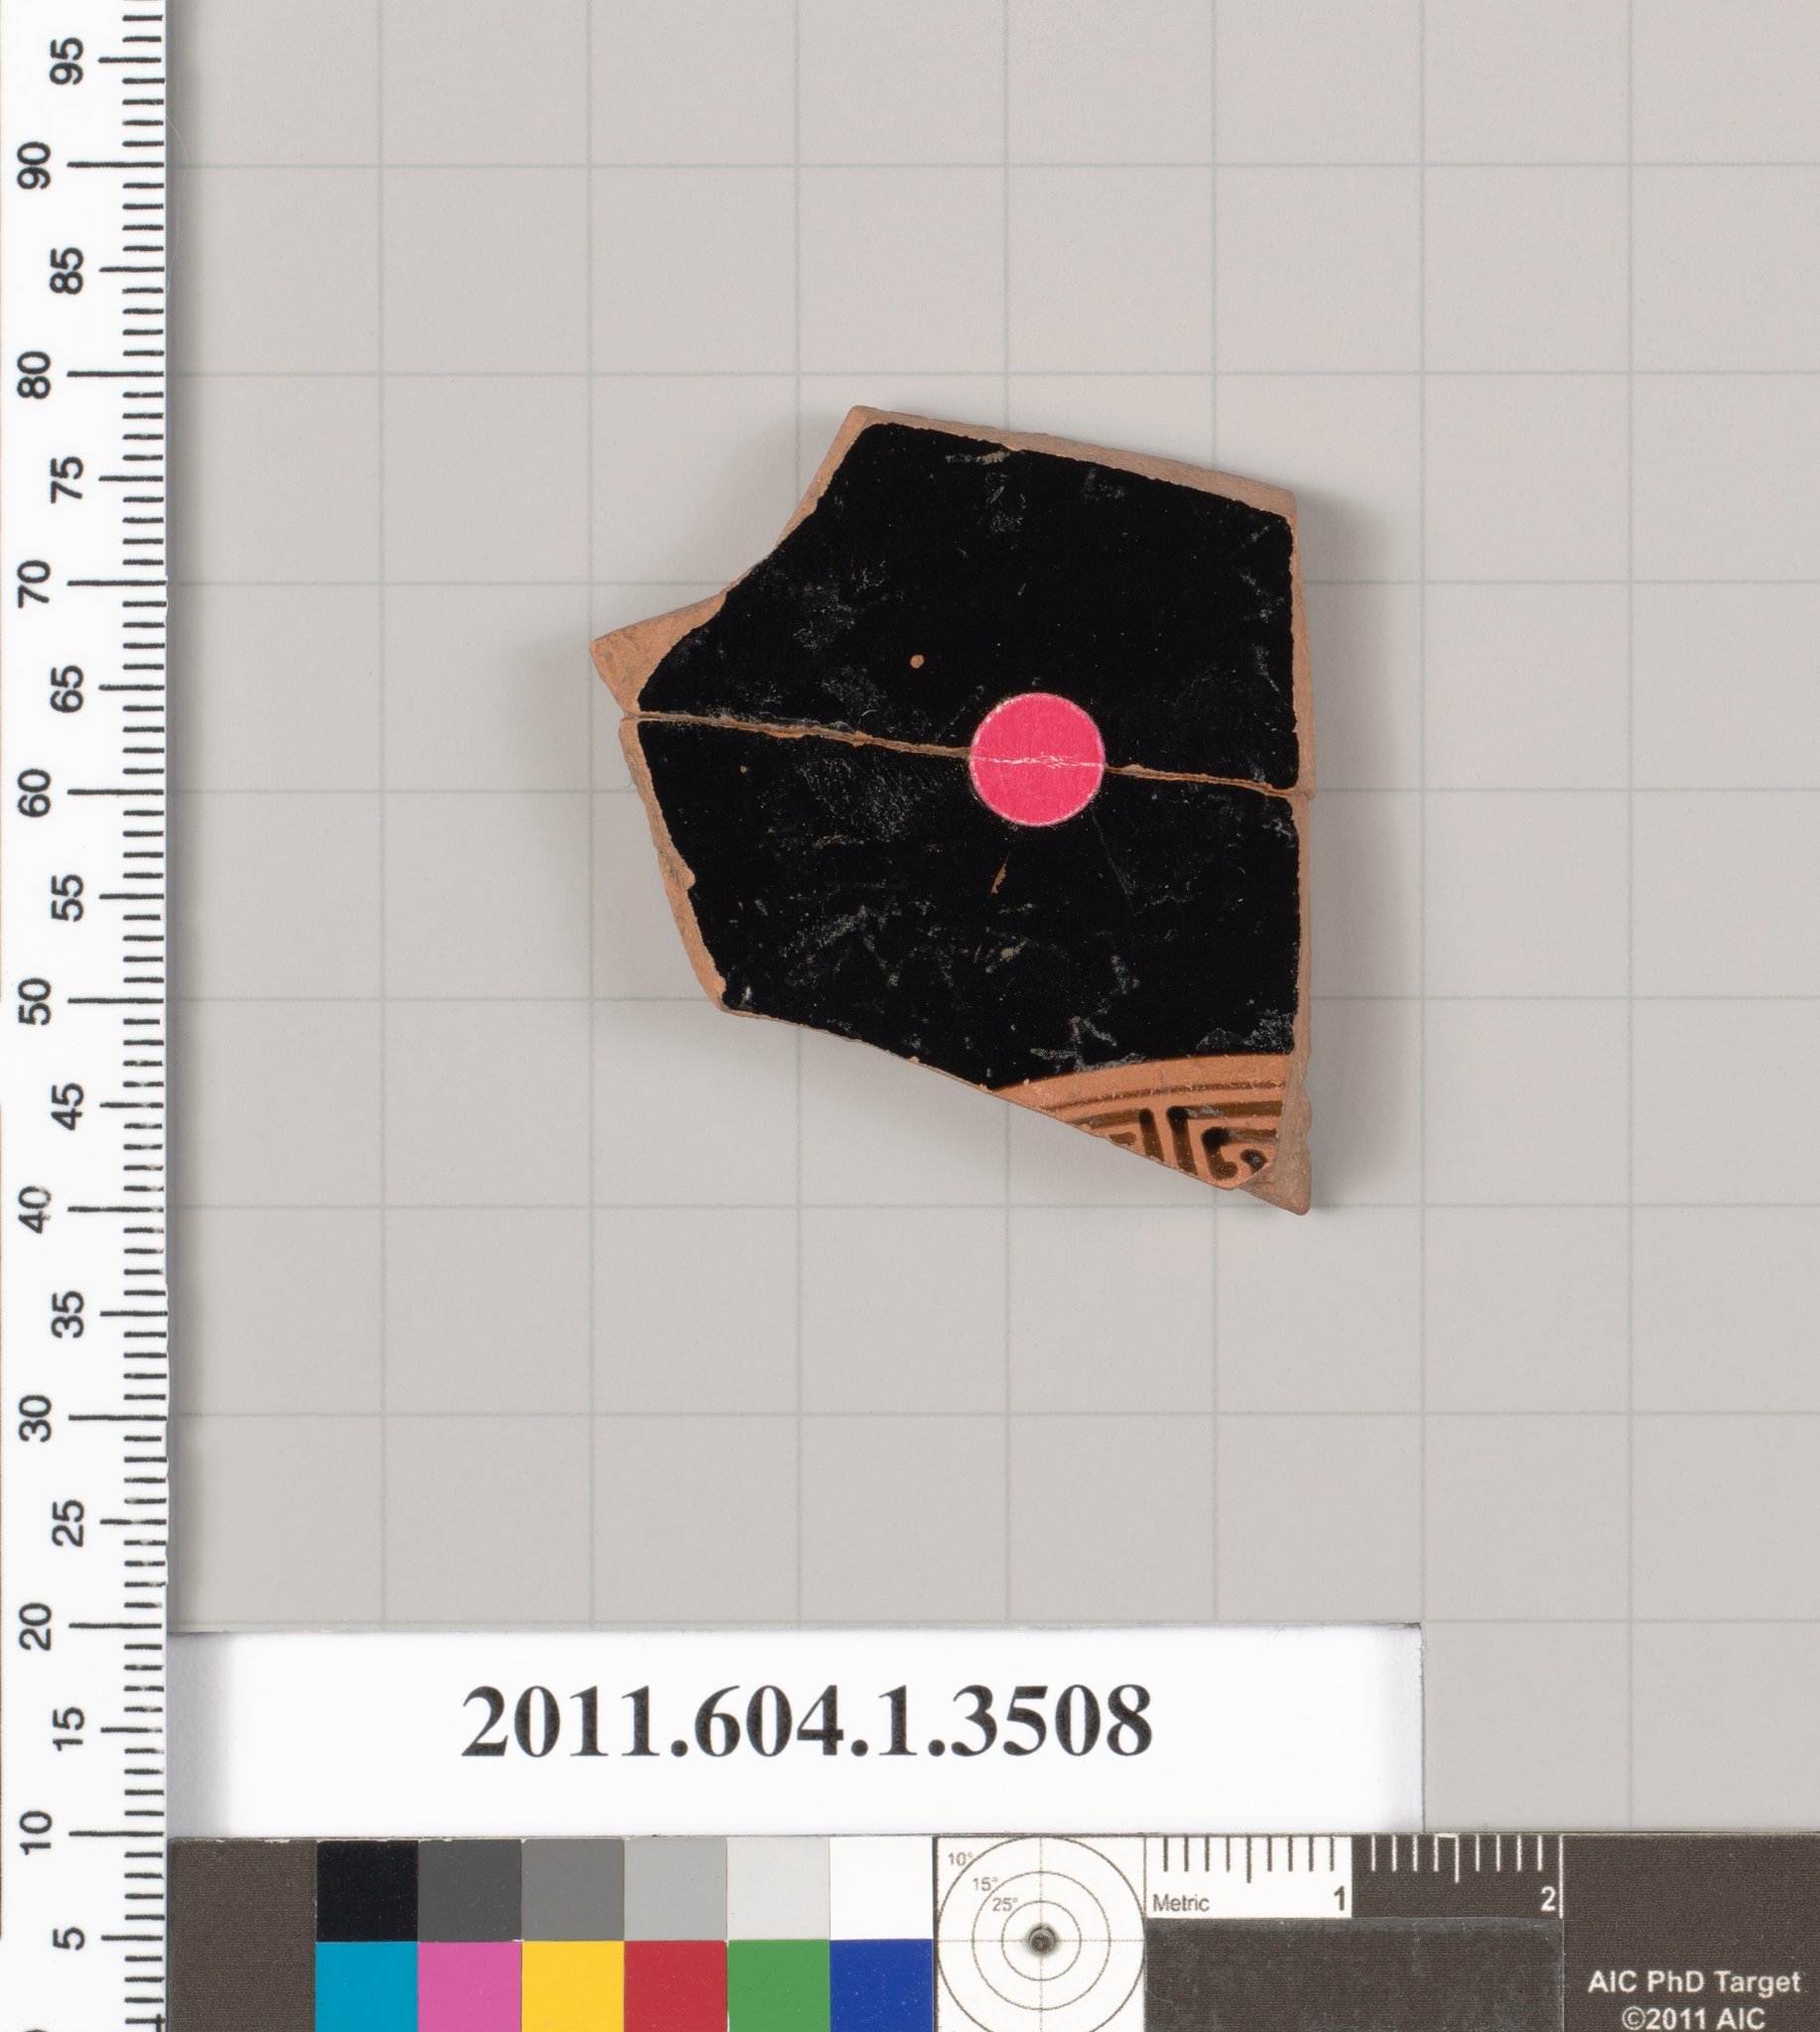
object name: kylix fragment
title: Terracotta fragment of a kylix (drinking cup)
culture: greek, attic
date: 490-480 BCE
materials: terracotta